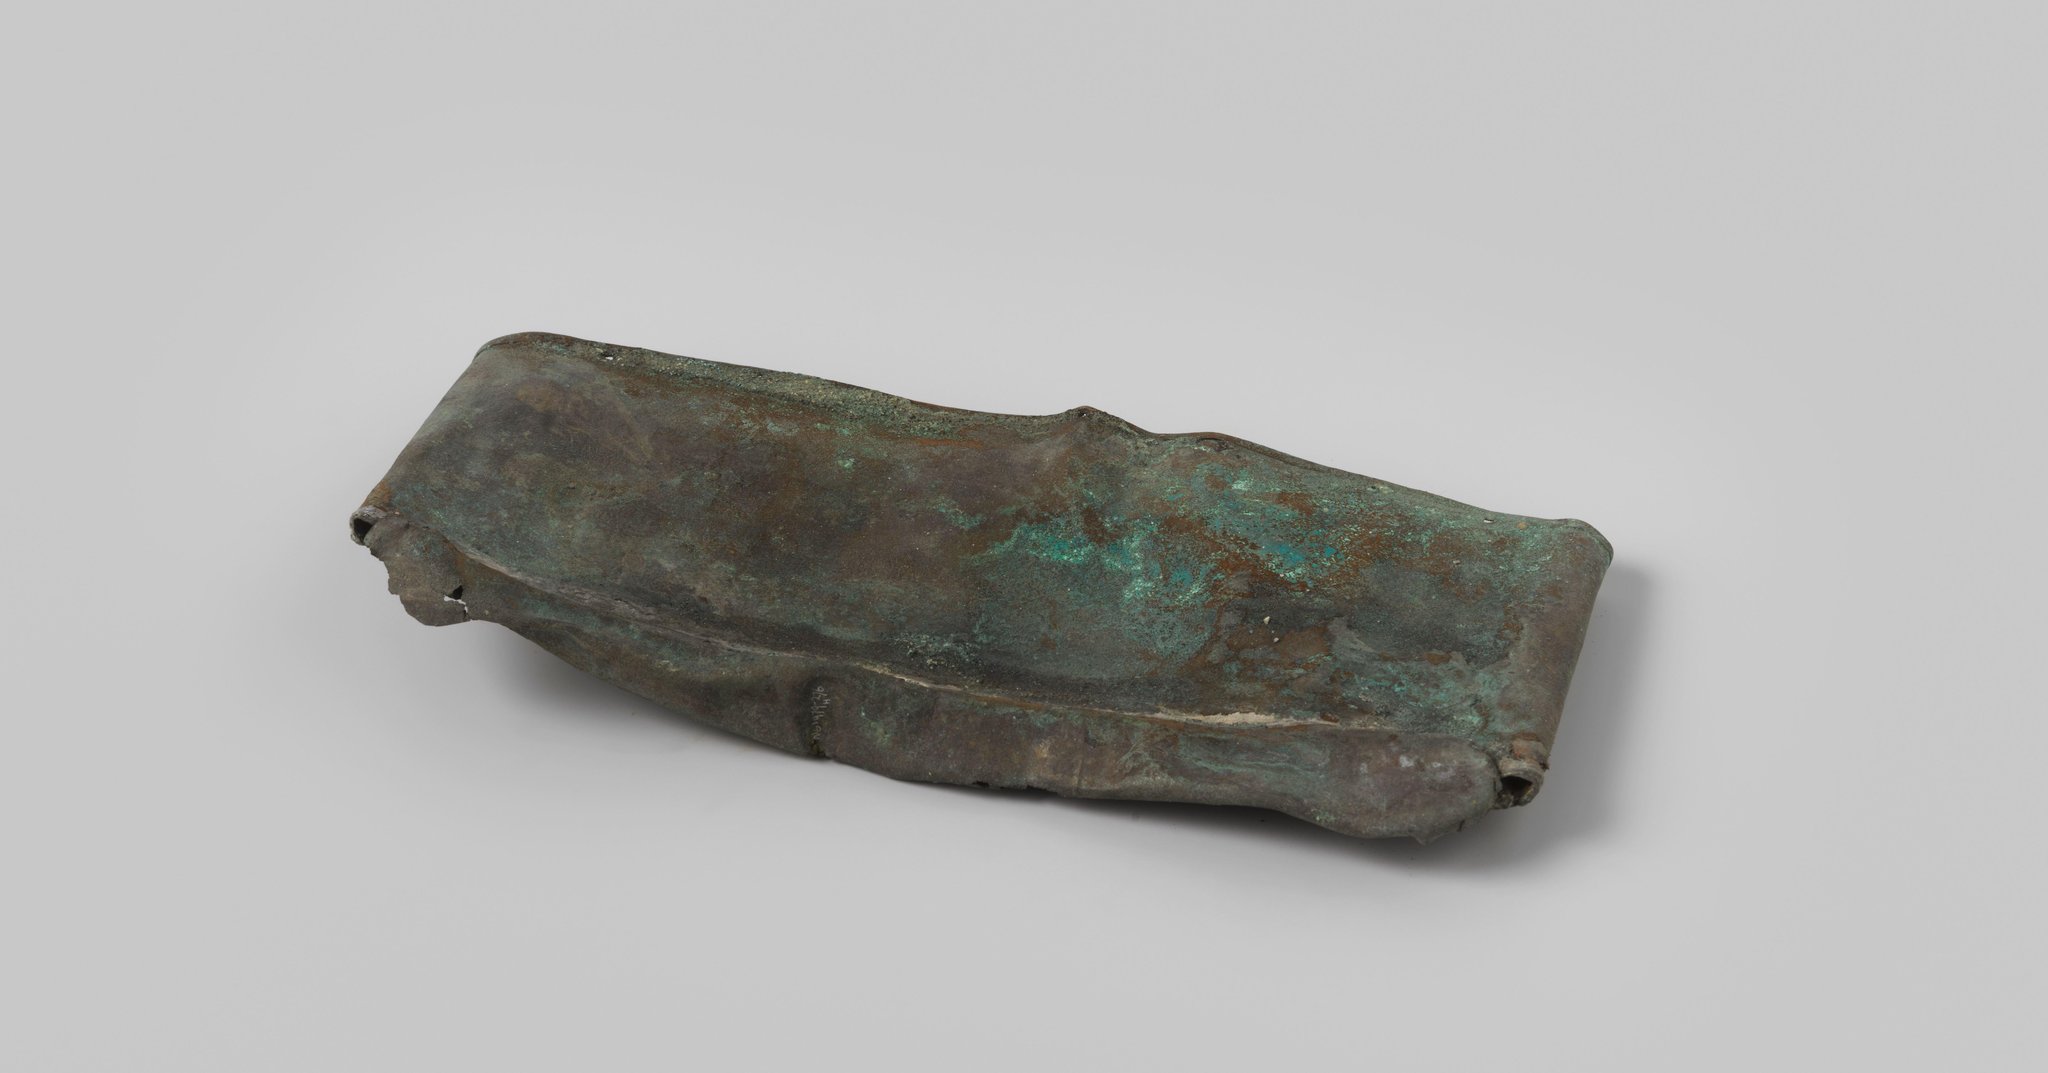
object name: cartridge pouch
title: Patroontas uit het wrak van de Oost-Indiëvaarder Hollandia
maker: Anonymous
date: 1700-1743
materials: copper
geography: netherlands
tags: verenigde oostindische compagnie, hollandia (schip), annet